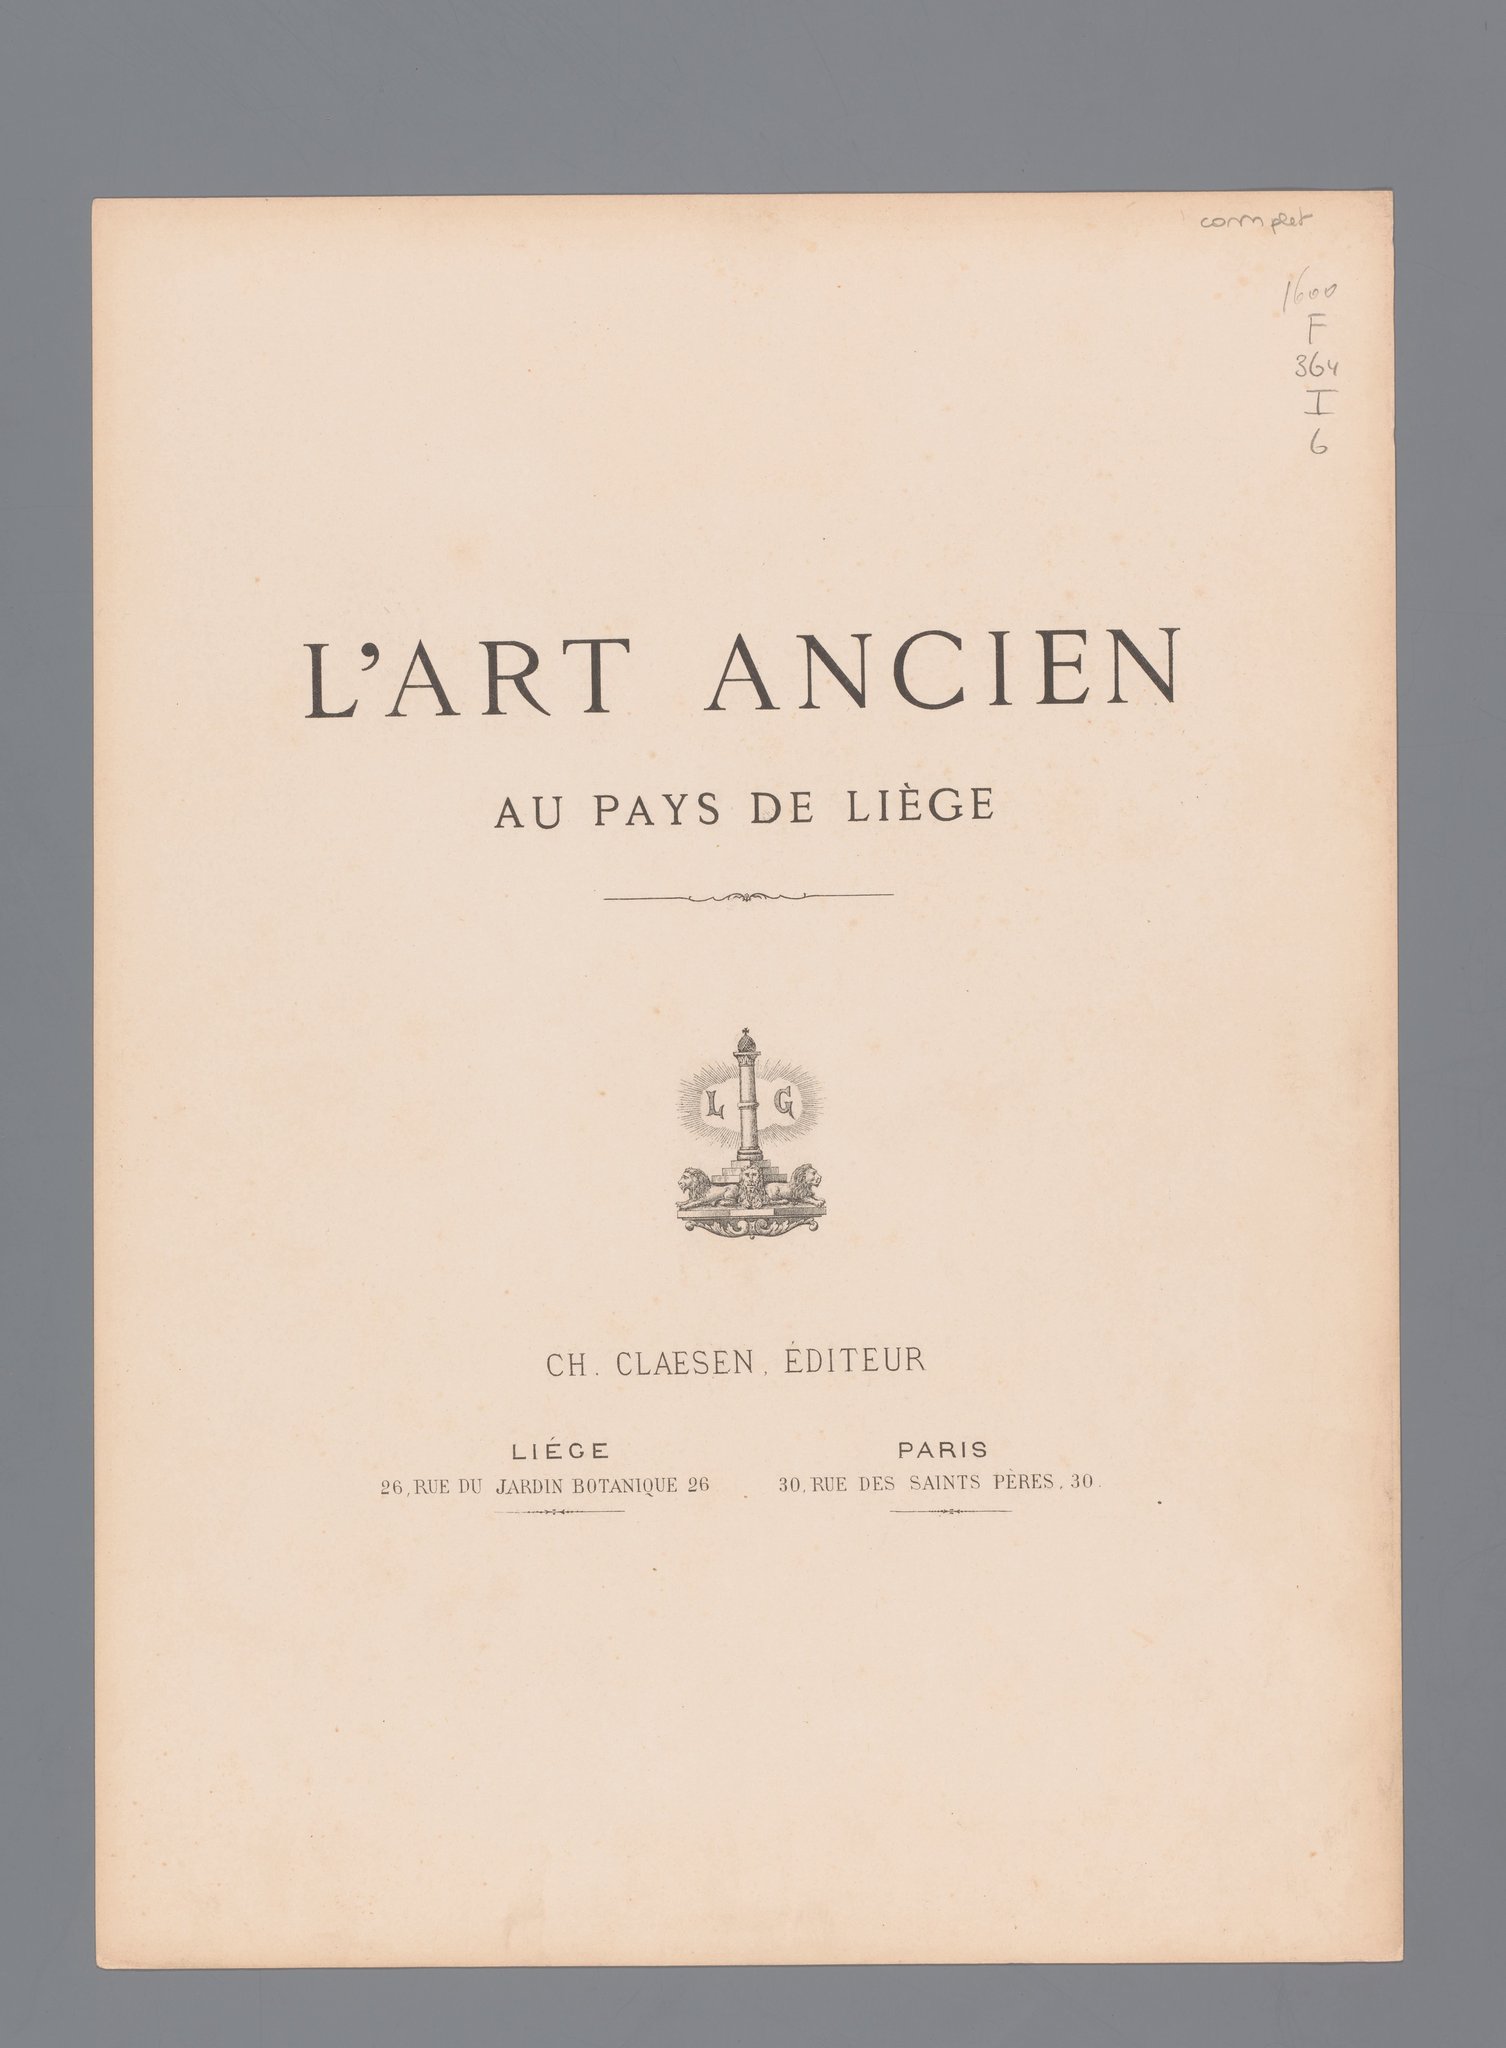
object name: wrapper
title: L'art ancien au pays de Liège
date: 1884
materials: cardboard, linen, paper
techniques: photograph, printing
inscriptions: annotation: ‘complet/ 1600’, date: ‘JULY/ 1988’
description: Omslag met twintig prenten, een titelblad en een lijst van afbeeldingen.